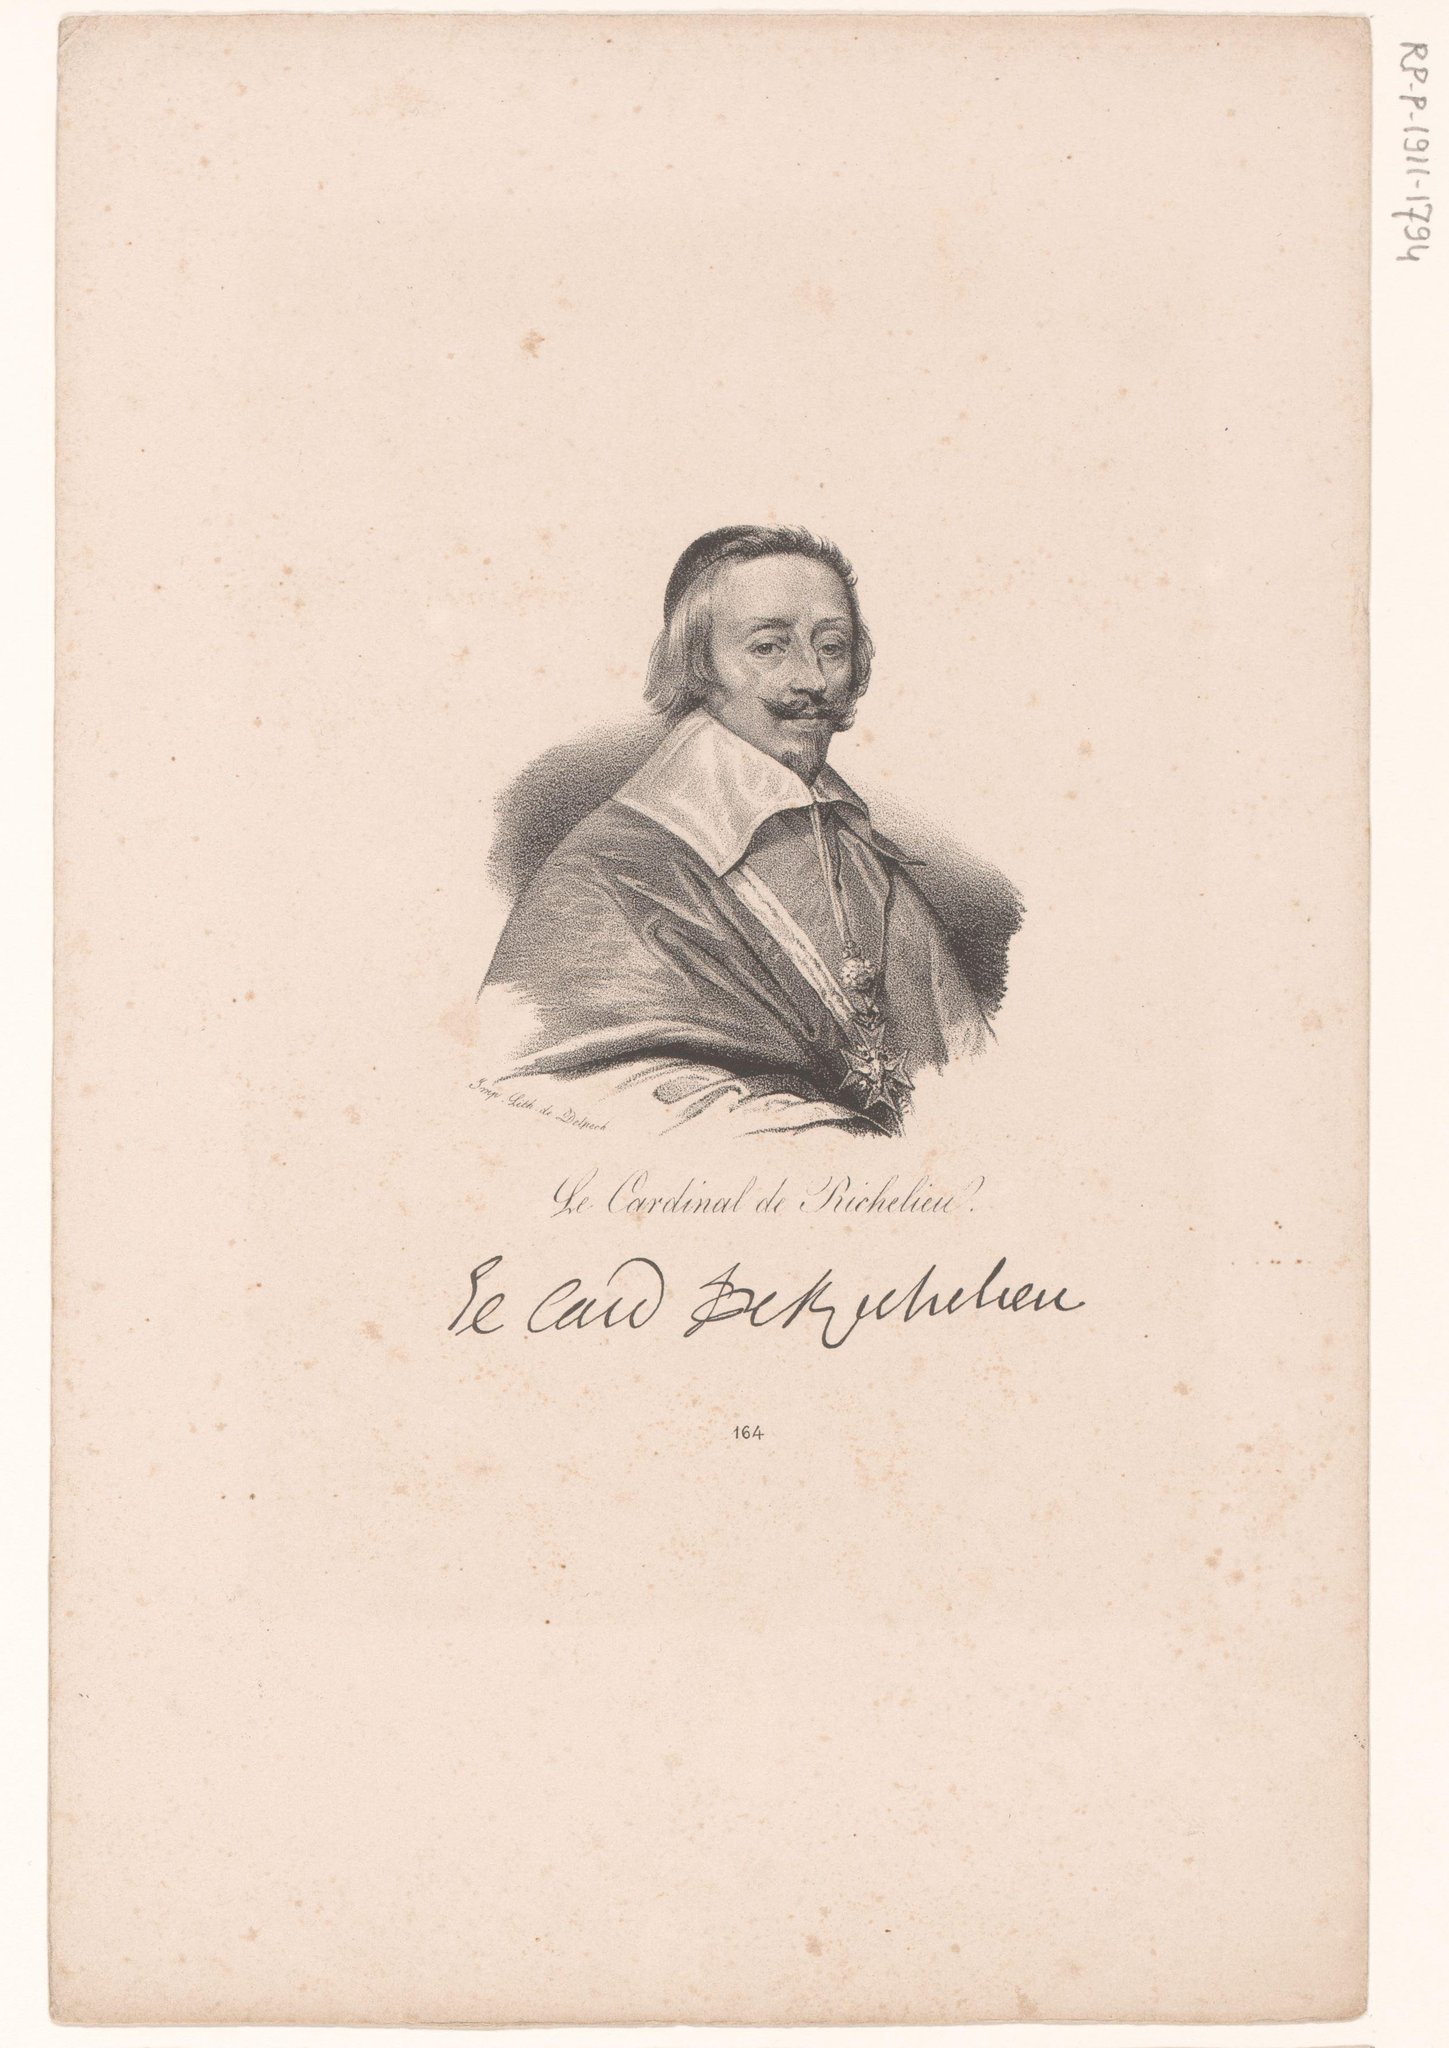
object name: print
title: Le Cardinal de Richelieu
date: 1818-1842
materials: paper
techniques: lithograph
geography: paris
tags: paris, armand-jean du plessis hertog van richelieu, historical persons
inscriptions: collector's mark: Lugt 2228a